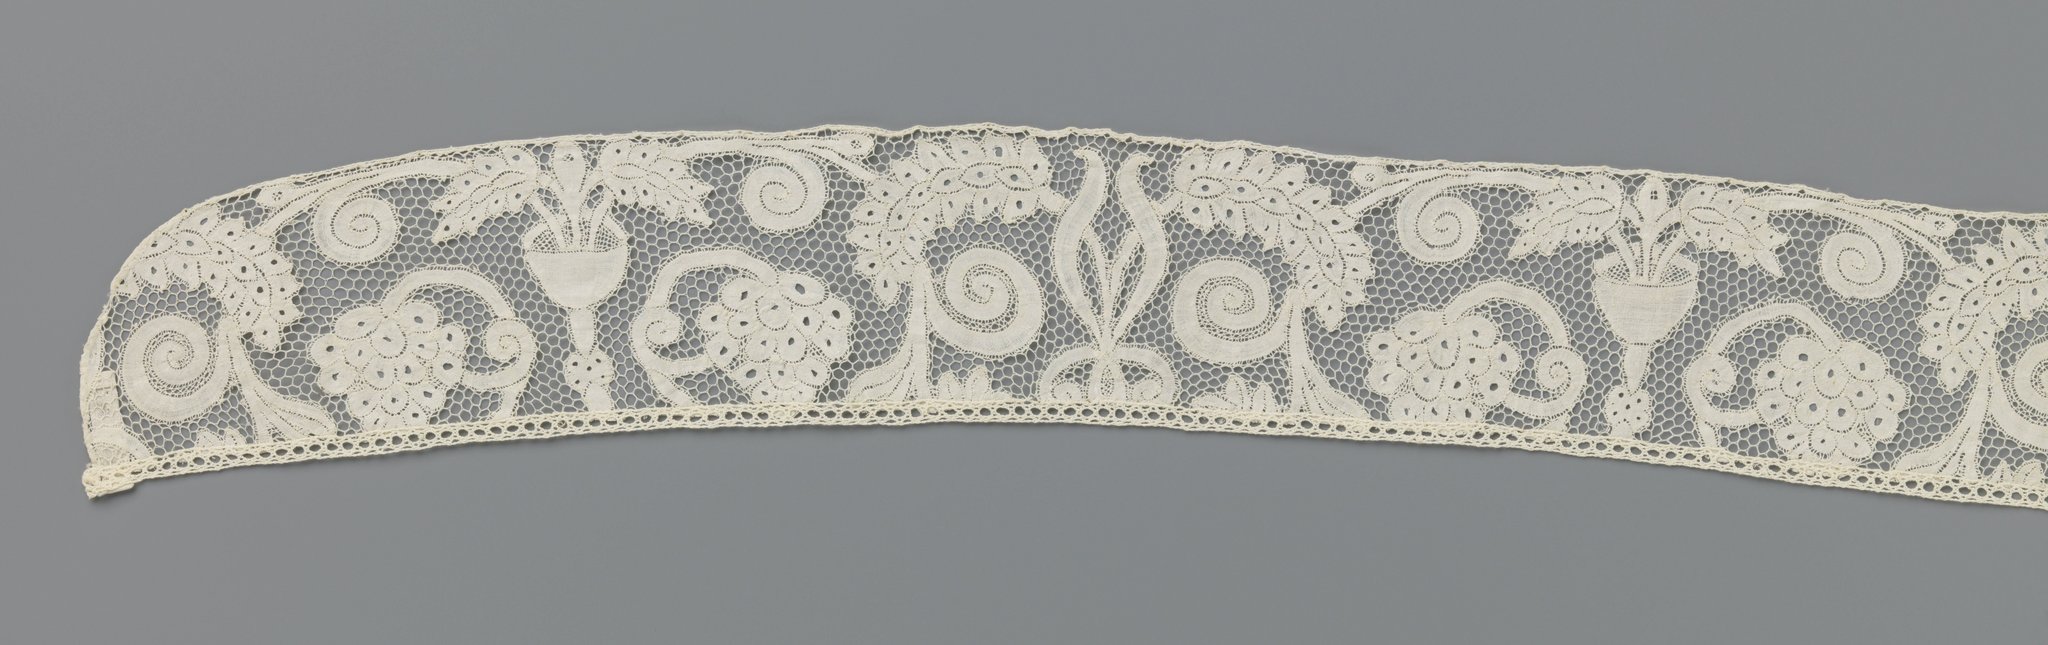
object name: bertha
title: Berthe van kloskant met druiventrossen en korenaren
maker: Anonymous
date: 1650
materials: linen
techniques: lace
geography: flanders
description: Berthe van naturelkleurige kloskant: Valenciennes-kant. Het zich herhalende en symmetrische patroon bestaat uit een kelk op een steel, waarin een naar rechts en naar links buigende korenaar staat. Achter beide korenaren langs loopt een lange omkrullende rank die aan beide zijden van de kelk eindigt in een druiventros. Tussen de opeenvolgende patronen met de kelk zijn met elkaar verbonden door twee veel grotere gebogen korenaren die met een lint aan elkaar zijn verbonden. De motieven zijn met elkaar verbonden door een ronde traliegrond: de ronde Valenciennes-grond. De motieven zijn gemaakt in linnenslag met opengewerkte randjes en met grote uitsparingen in de druiventros en in de korenaren. De onderkant is recht afgewerkt. De bovenrand is afgewerkt met een apart geklost bandje met veel grovere garen. De korte kanten zijn afgerond en afgewerkt met een zoompje.